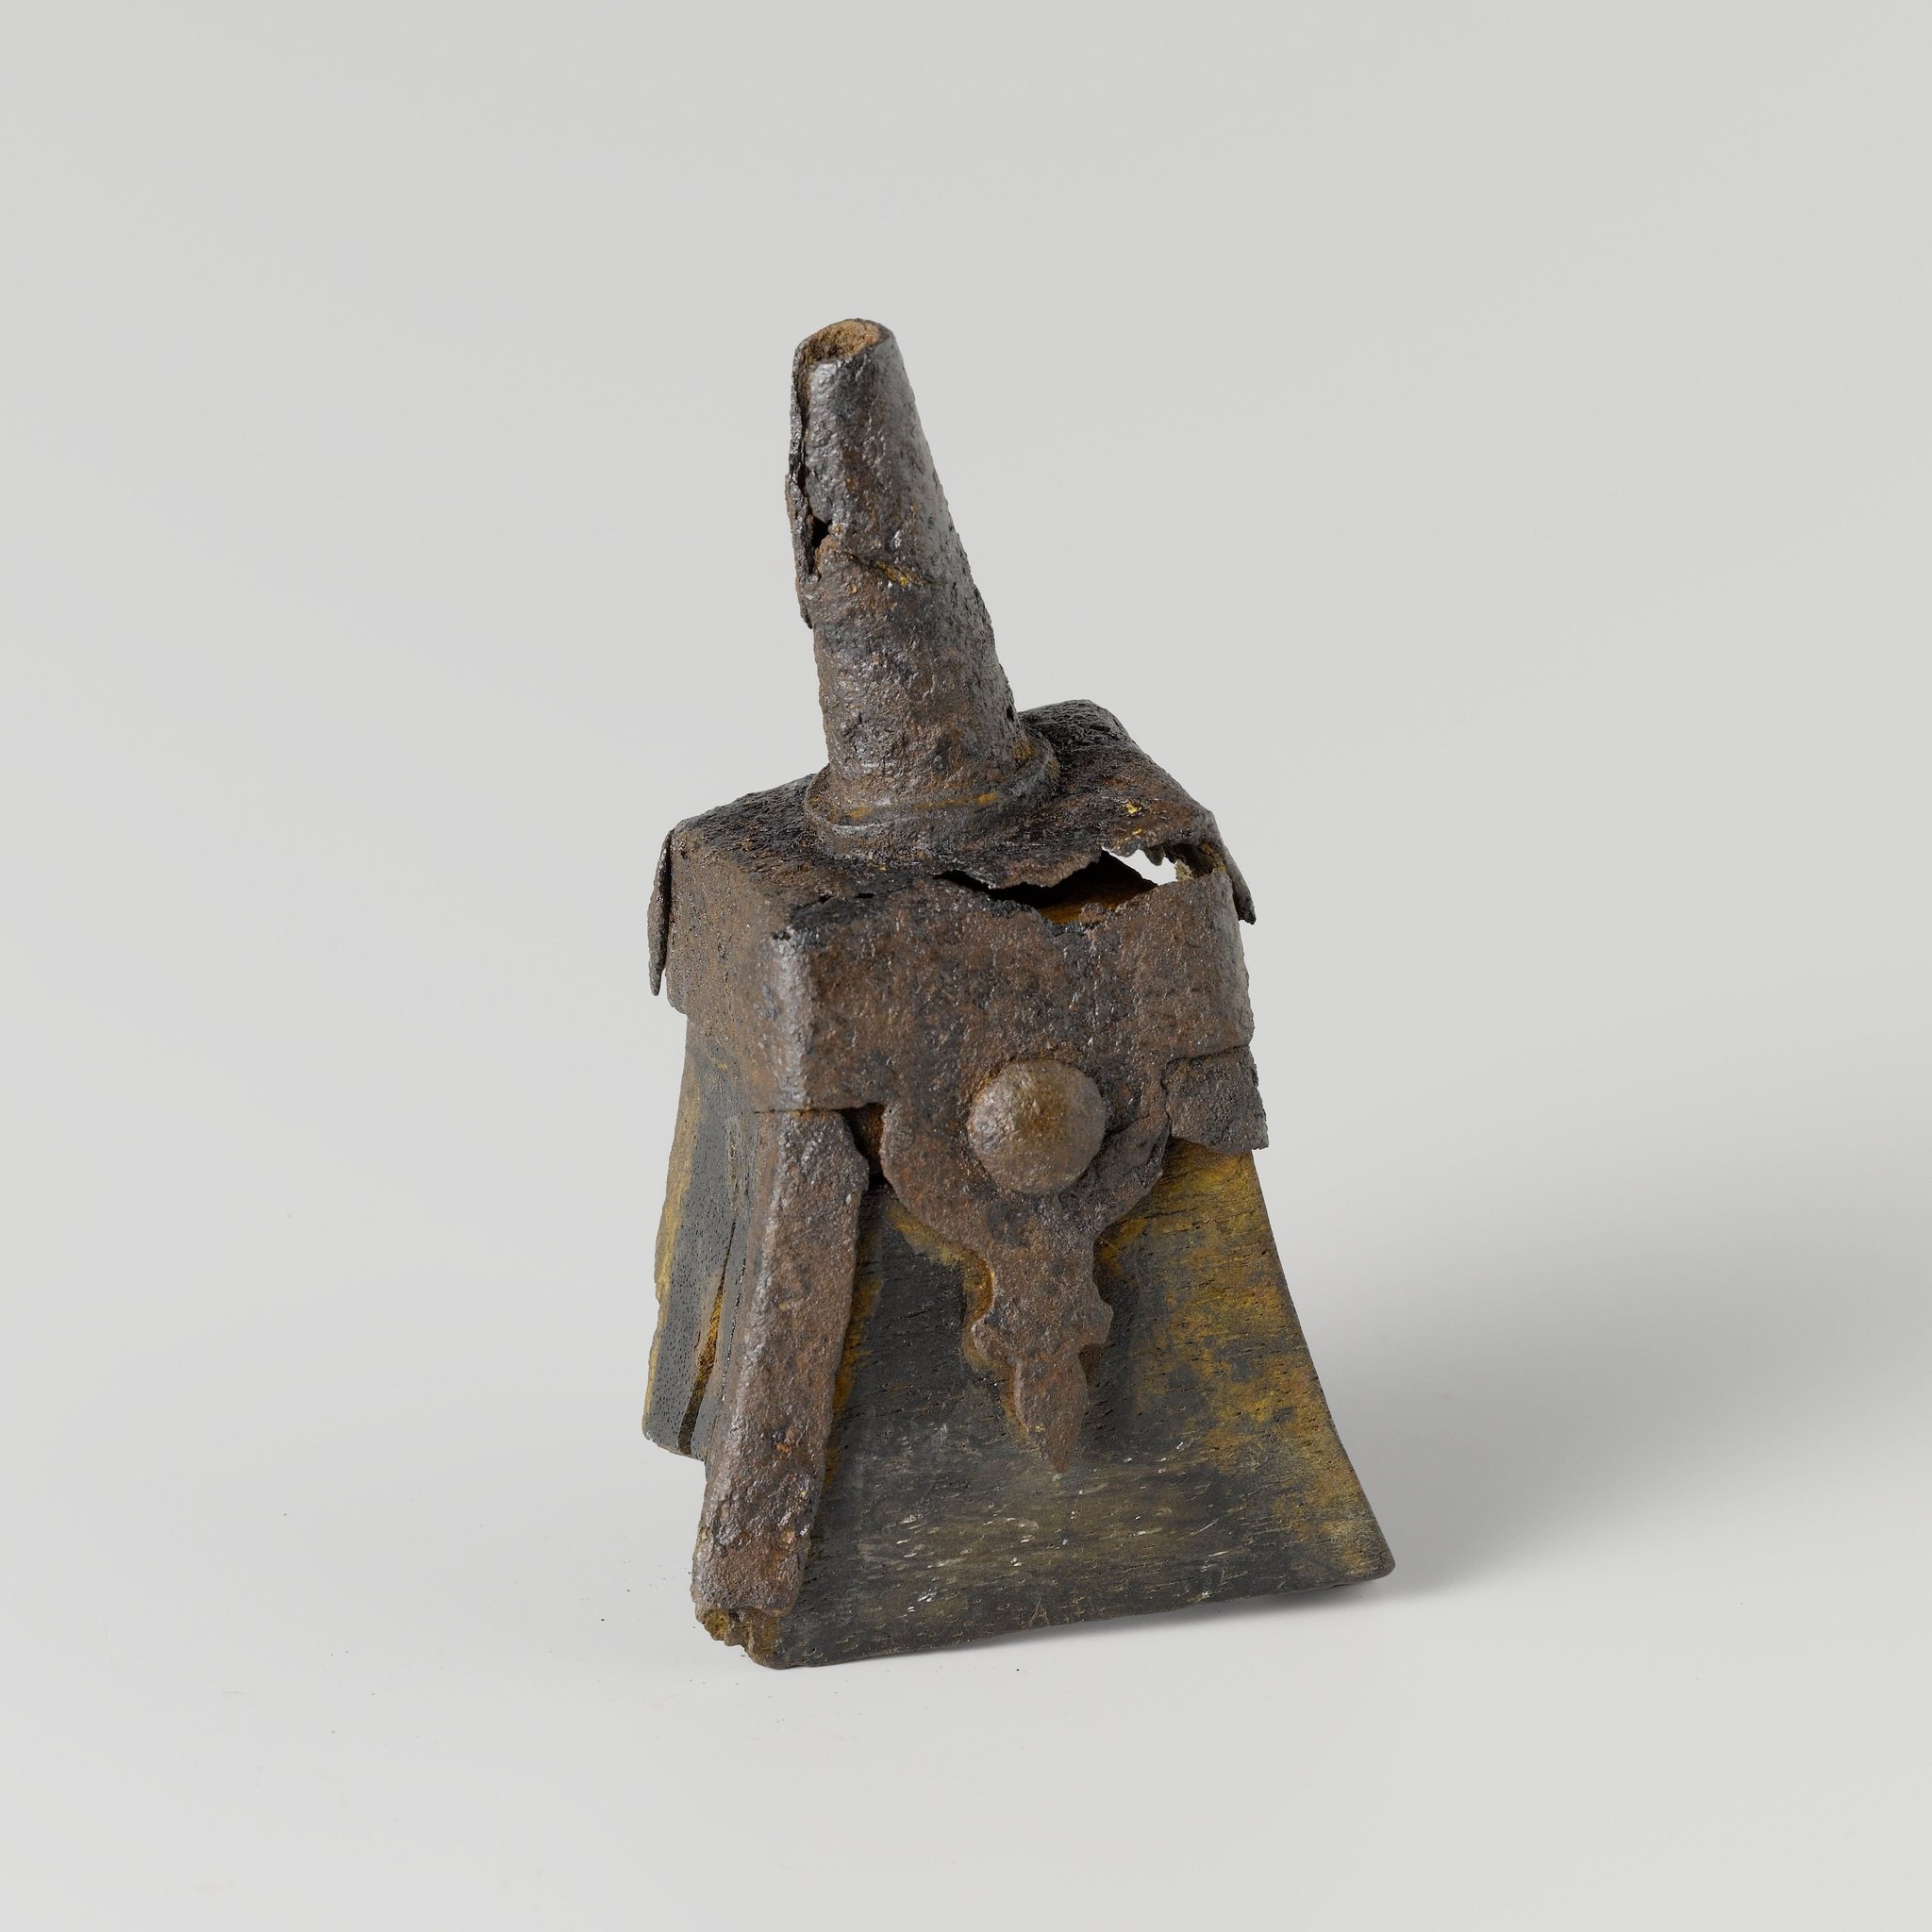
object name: fragment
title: Fragment van een blaasbalg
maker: Anonymous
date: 1590-1596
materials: iron, wood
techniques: forging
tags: willem barendsz., amsterdam, jacob van heemskerck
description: Part of the tip of a pair of bellows